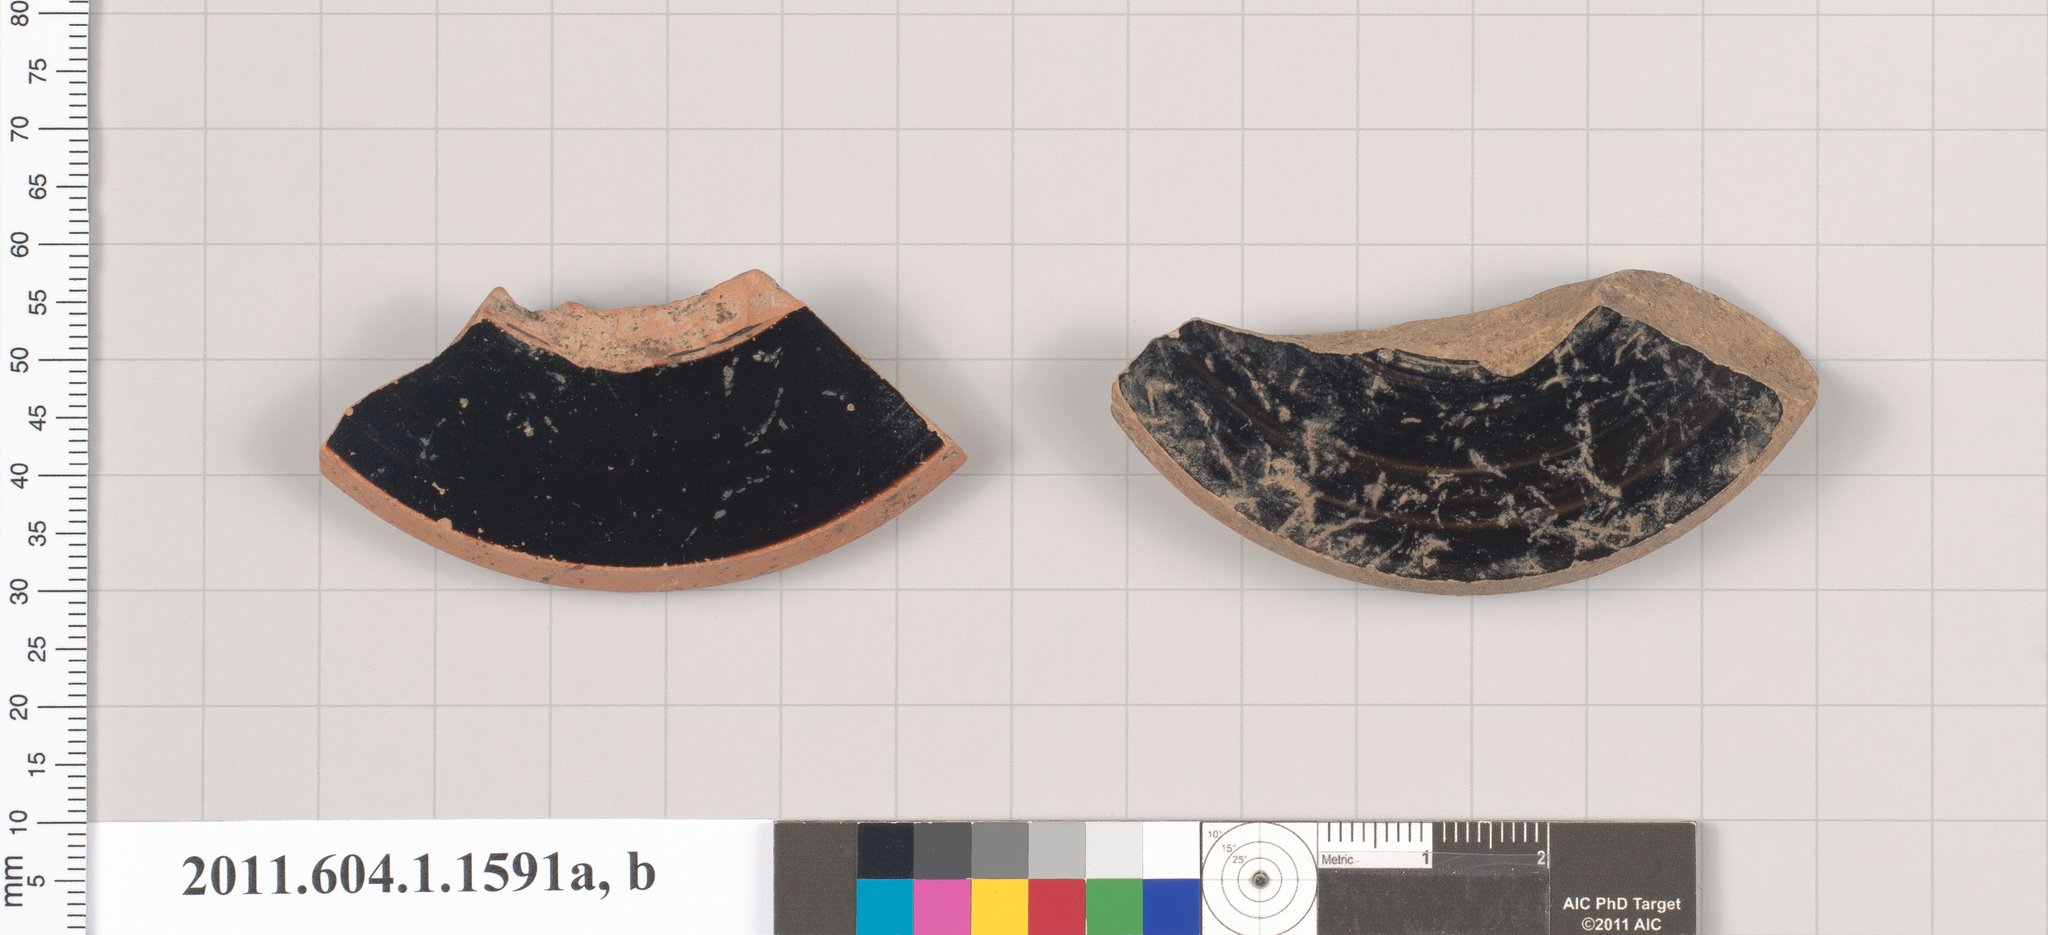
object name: kylix fragment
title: Terracotta fragments of kylikes (drinking cups)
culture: greek, attic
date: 500-401 BCE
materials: terracotta